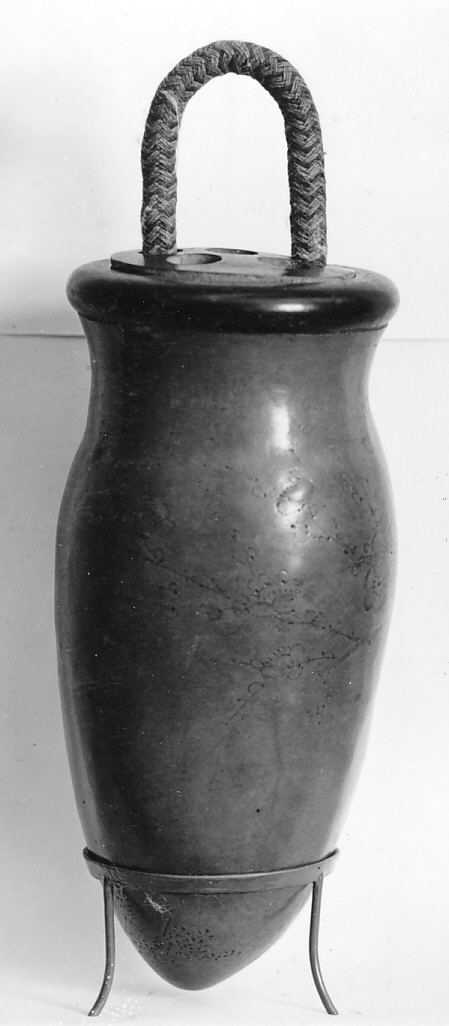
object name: cricket cage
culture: chinese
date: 1701-1900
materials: wood